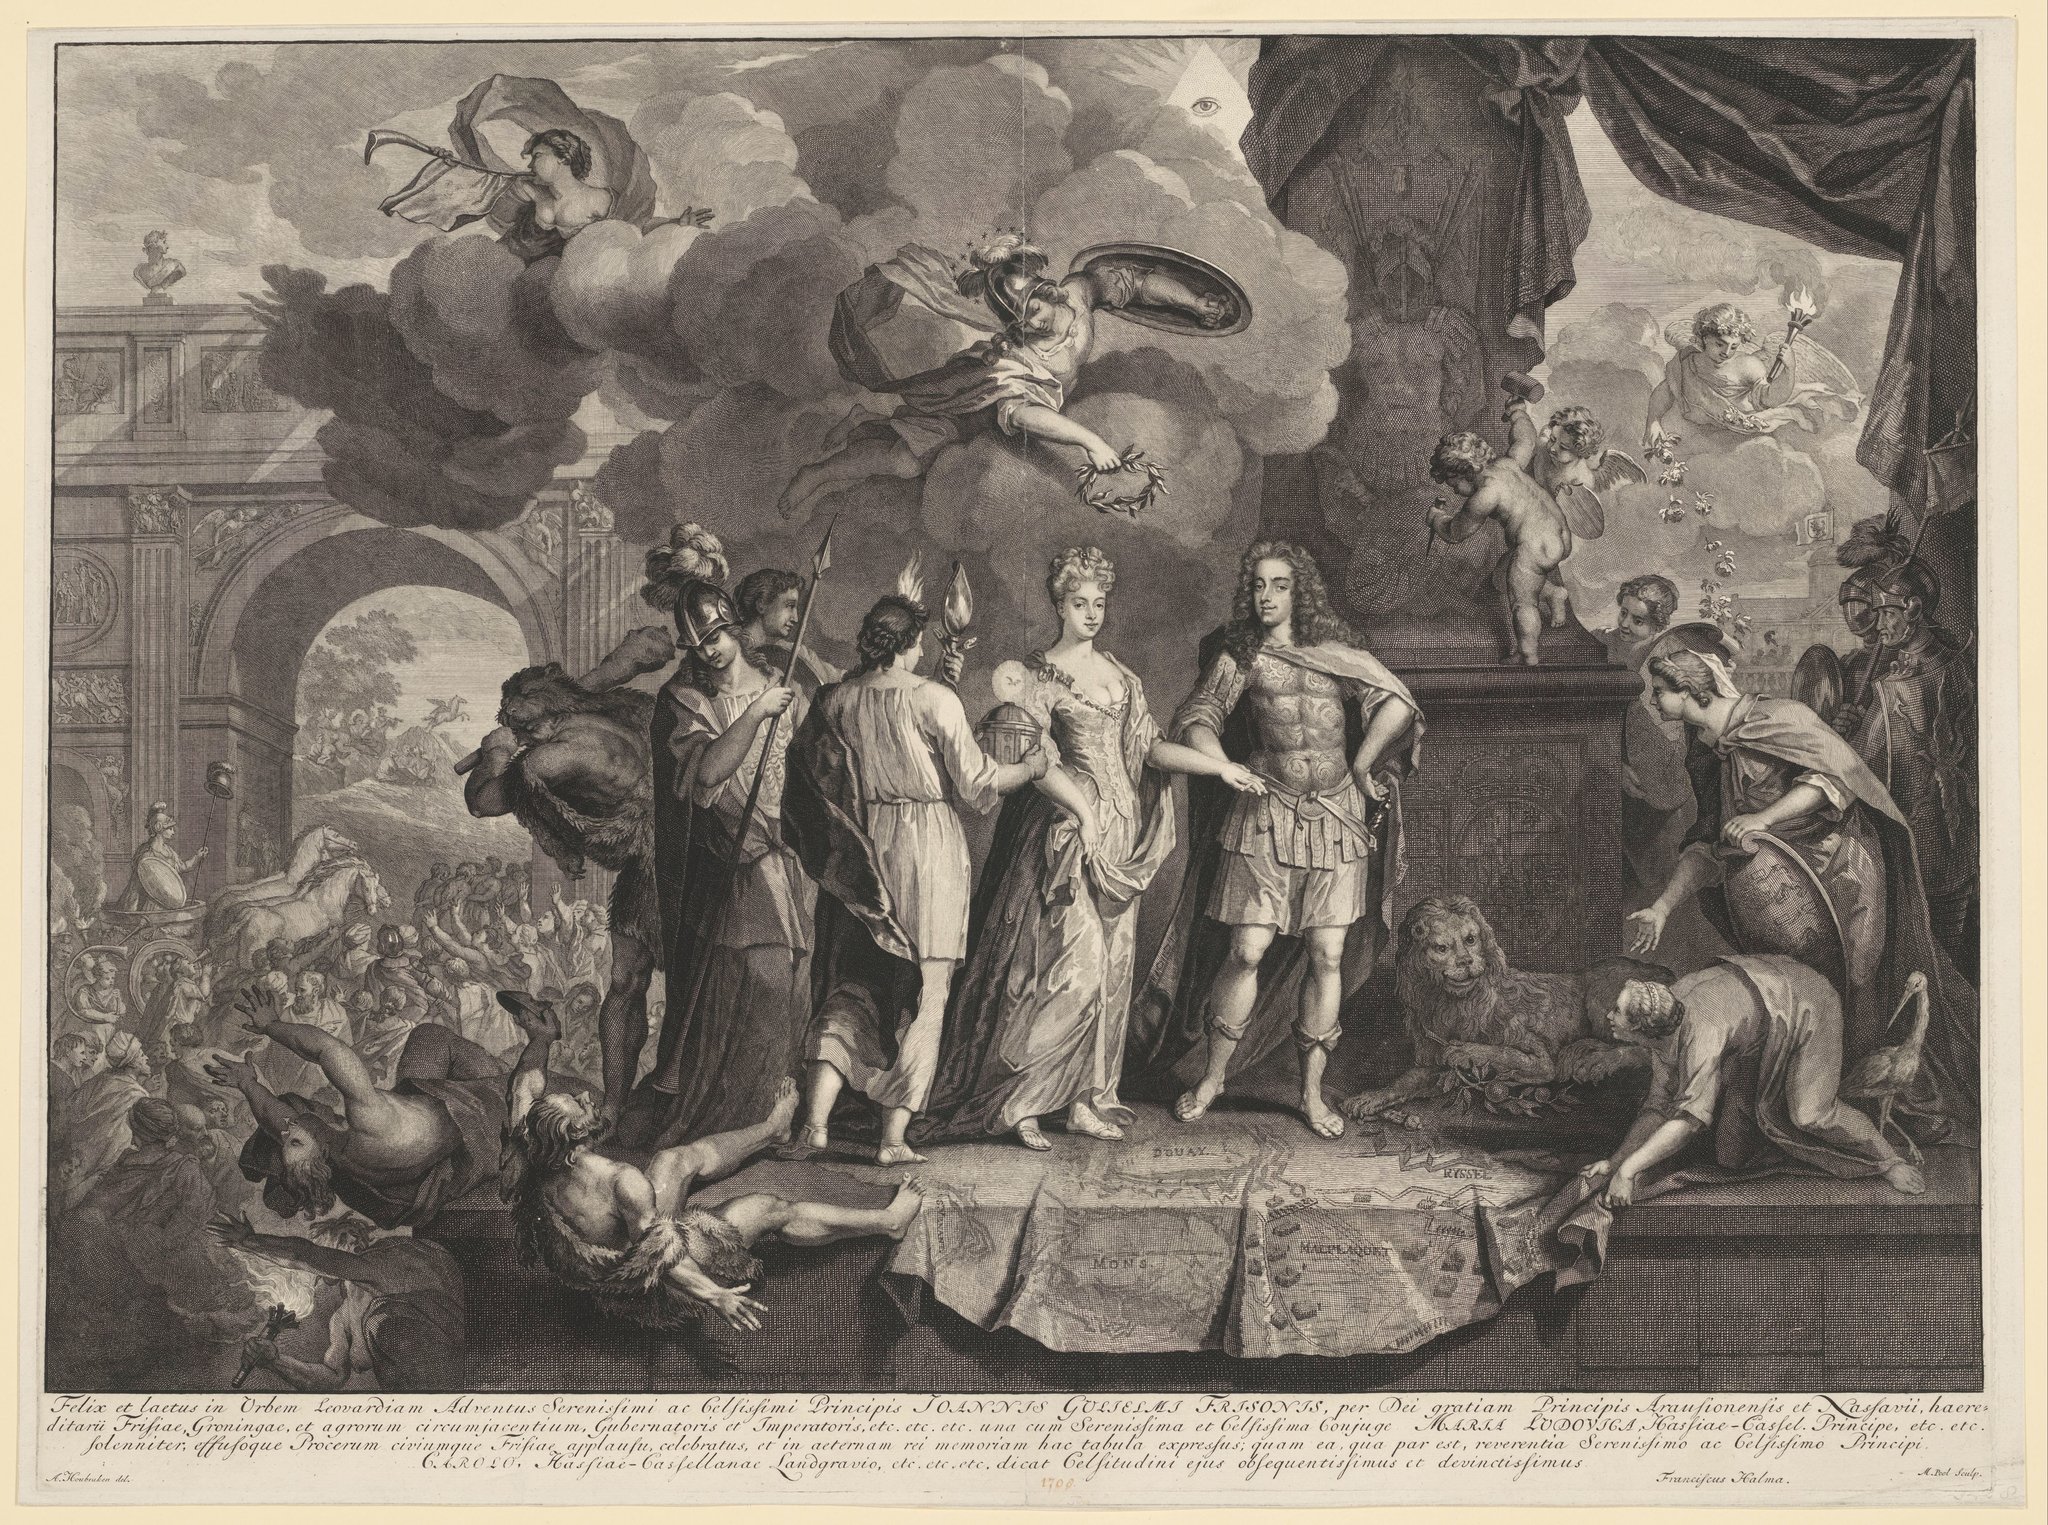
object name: print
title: Allegorie op intocht van Johan Willem Friso en Maria Louise in Leeuwarden, 1710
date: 1710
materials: paper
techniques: engraving, etching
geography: northern netherlands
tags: johan willem friso (prins van oranje-nassau), triumphal entry and public reception, pageant, 'entrée solennelle', 'joyeuse entrée', symbolic triumphs of individual persons, parnassus, sacred to apollo musagetes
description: Allegorie op intocht van prins Johan Willem Friso en prinses Maria Louise te Leeuwarden op 2 januari 1710. Centraal de prins en prinses van Oranje met de personificaties van Wijsheid, Voorzichtigheid en Godsdienst, Hercules slaat Bedrog, Laster en Afgunst in de afgrond. Rechts spreidt de Waakzaamheid een kleed waarop de militaire overwinningen van de prins zijn uitgebeeld, hierbij ook de Nederlandse Leeuw en de provinciemaagd van Friesland. Links een intocht door een triomfpoort (van de Nederlandse Maagd of Vrijheid), op de achtergrond de Parnassus met Apollo, Pegasus en de Muzen. In de wolken de Faam, het Alziende Oog en de Eer. Rechts op de achtergrond een gebouw dat lijkt op het Stadhuis (bouw begonnen in 1715). In het onderschrift de opdracht in het Latijn aan de landgraaf van Hessen-Kassel, de vader van de prinses van Oranje.